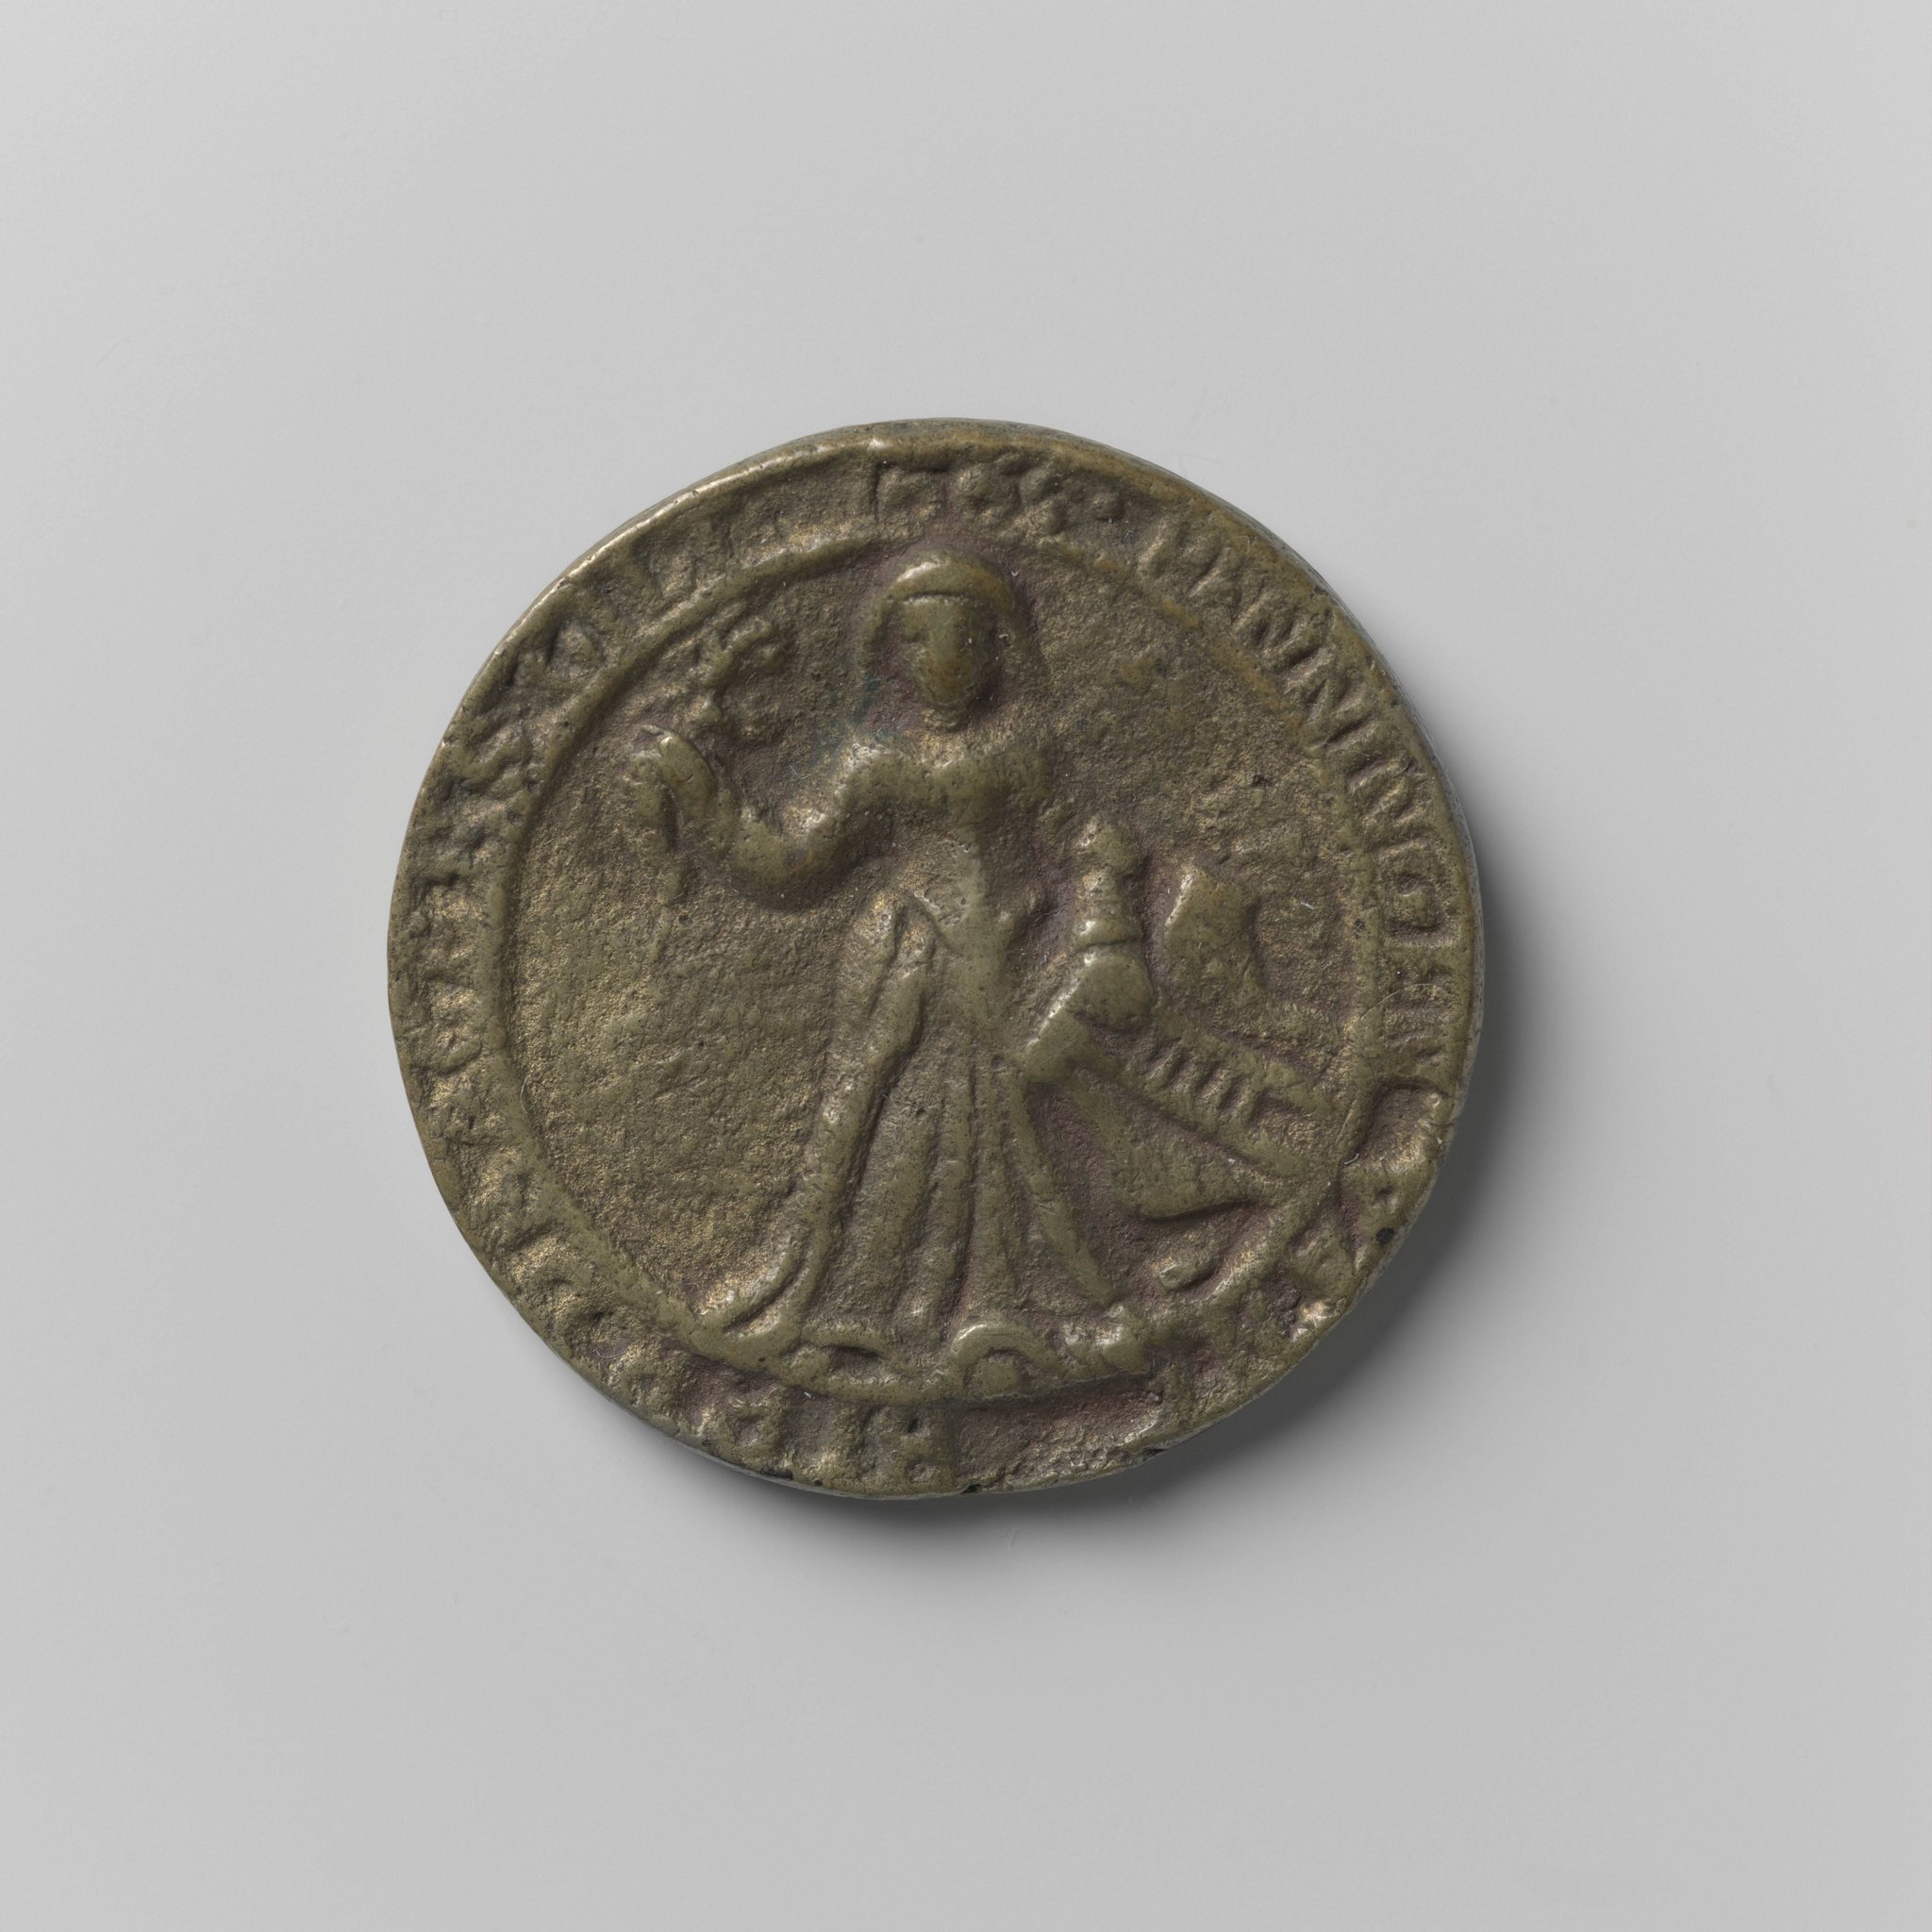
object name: medal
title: Bierdragersgilde van Amsterdam, gildepenning van Joost Rens Huyen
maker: Anonymous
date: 1665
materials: brass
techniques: casting, engraving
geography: amsterdam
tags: amsterdam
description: Messing penning. Voorzijde: vrouw met tak hoppe in geheven rechter- en schild met daarop een draagberrie in linkerhand binnen omschrift. Keerzijde: twee mannen, die tussen hun in vat aan draagstok houden; afsnede:opschrift